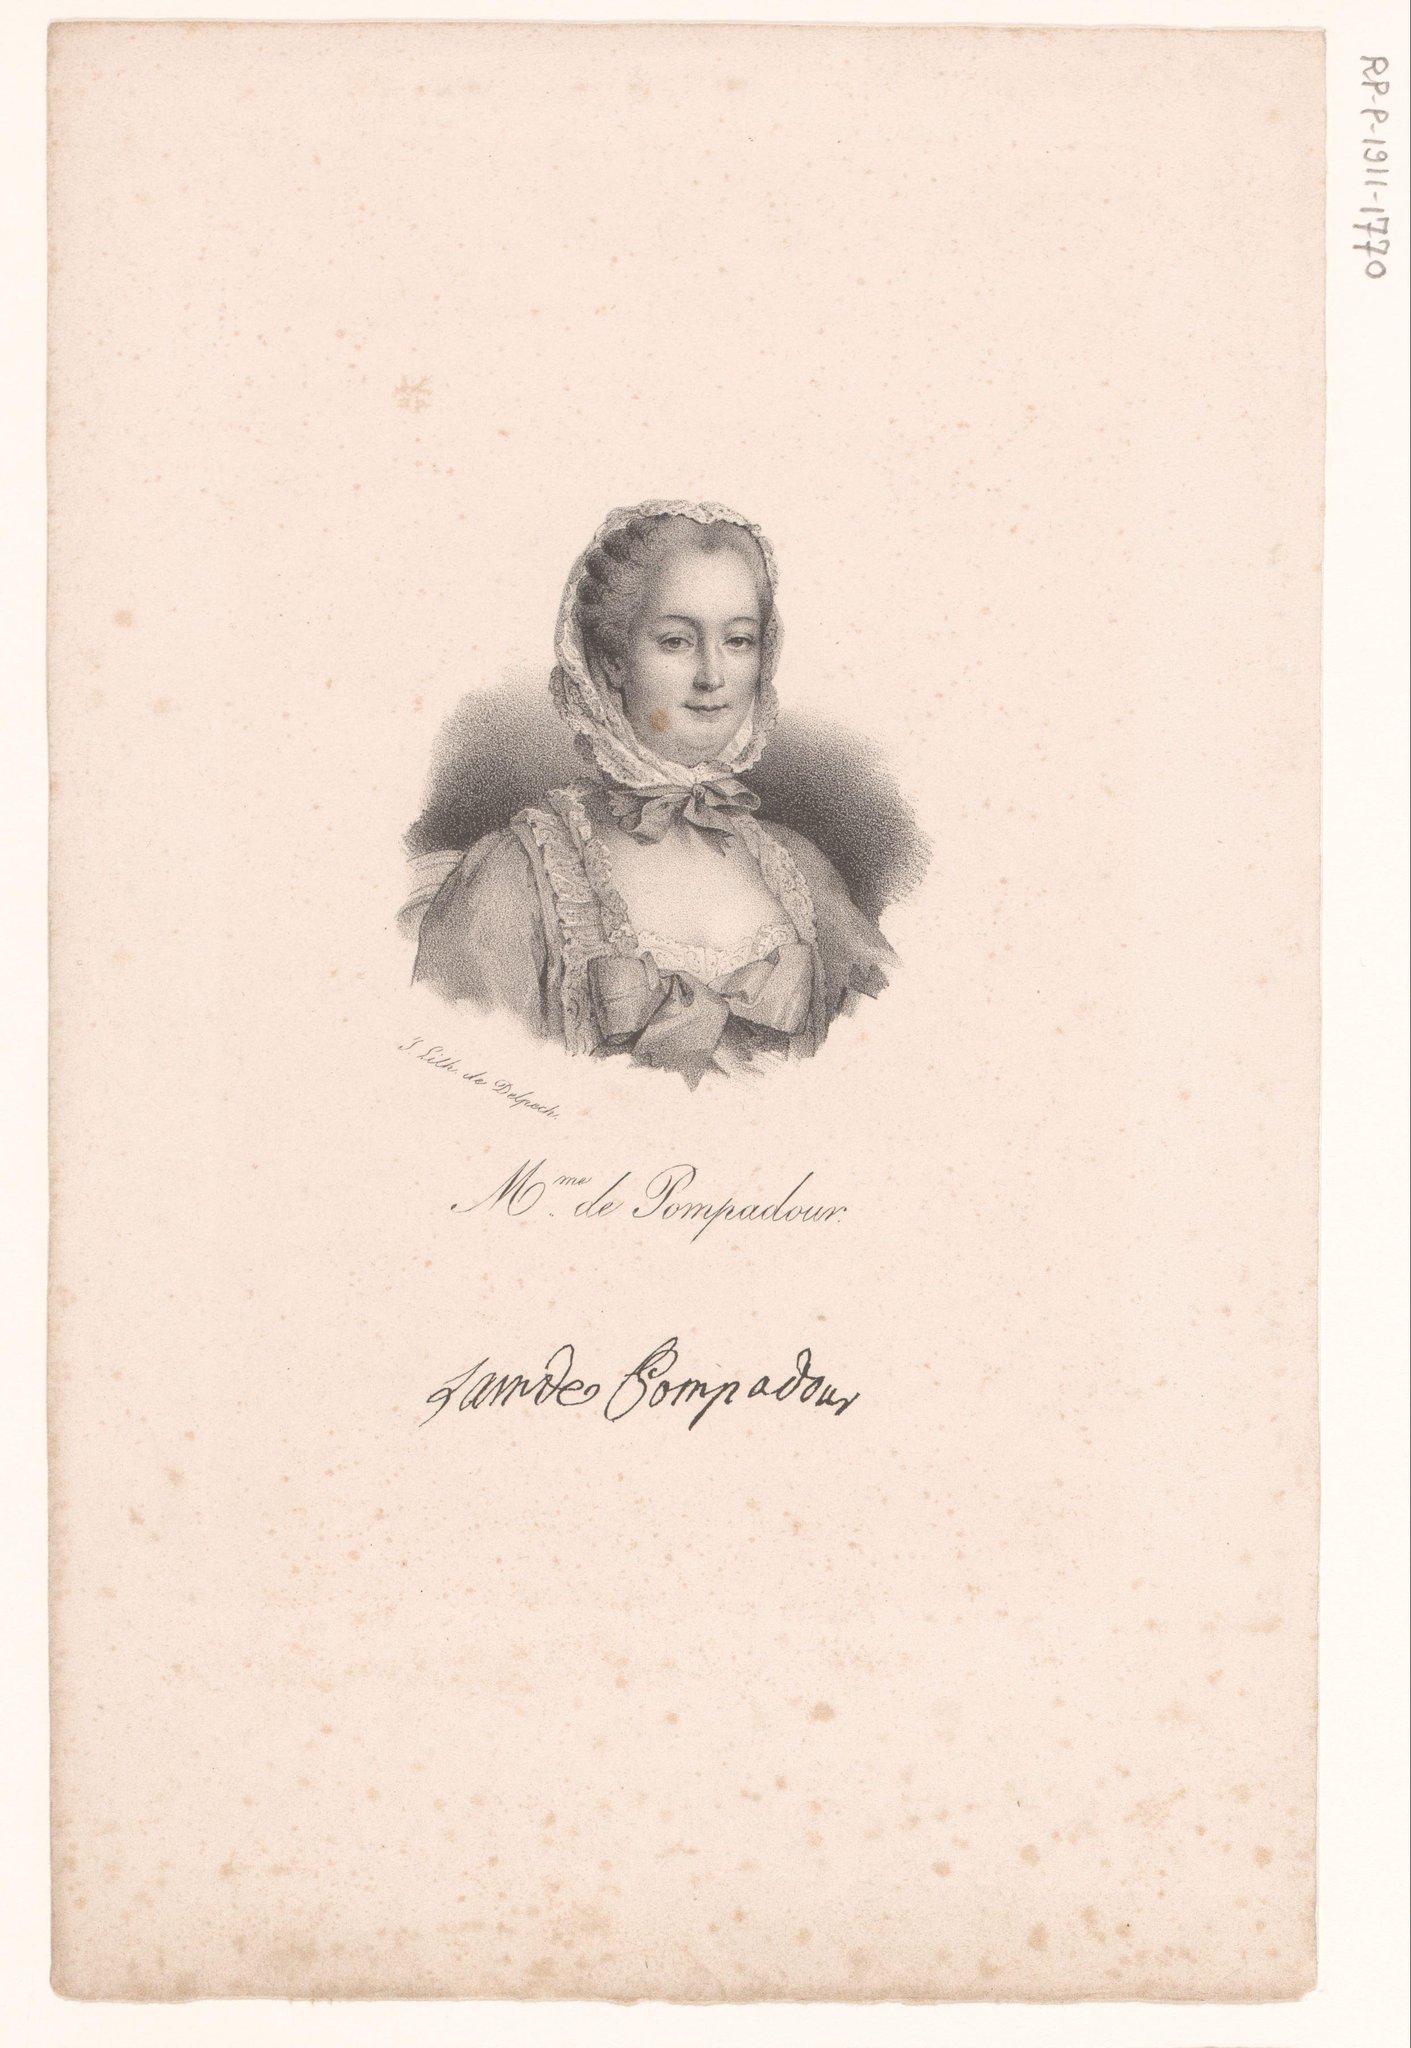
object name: print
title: M.me de Pompadour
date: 1818-1842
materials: paper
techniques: lithograph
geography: paris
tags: paris, print maker, madame de pompadour, historical persons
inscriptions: collector's mark: Lugt 2228a